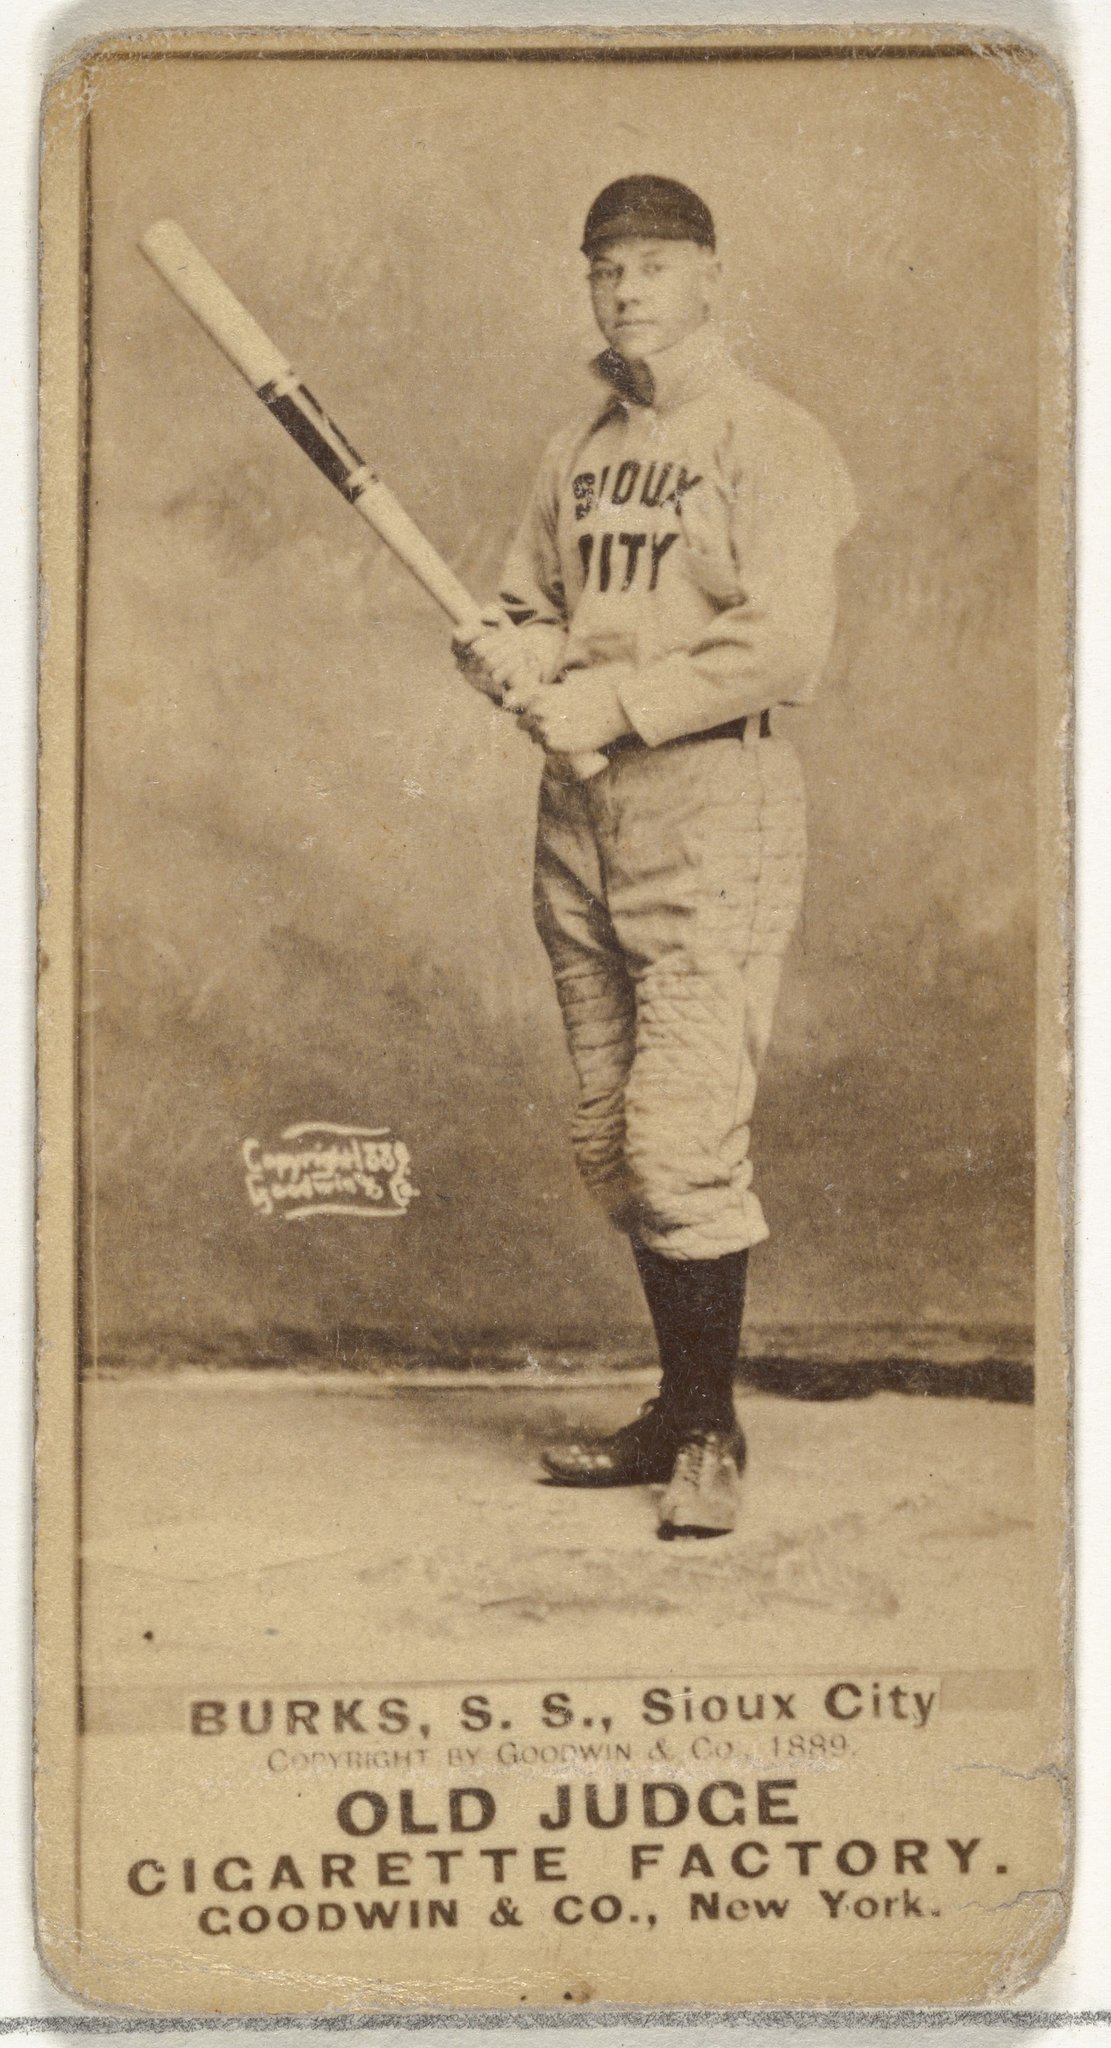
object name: baseball card, photograph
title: Robert E. Burks, Shortstop, Sioux City Corn Huskers, from the Old Judge series (N172) for Old Judge Cigarettes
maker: goodwin & company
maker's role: publisher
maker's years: 1850-1950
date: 1889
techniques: albumen silver print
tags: men,portraits,baseball,athletes